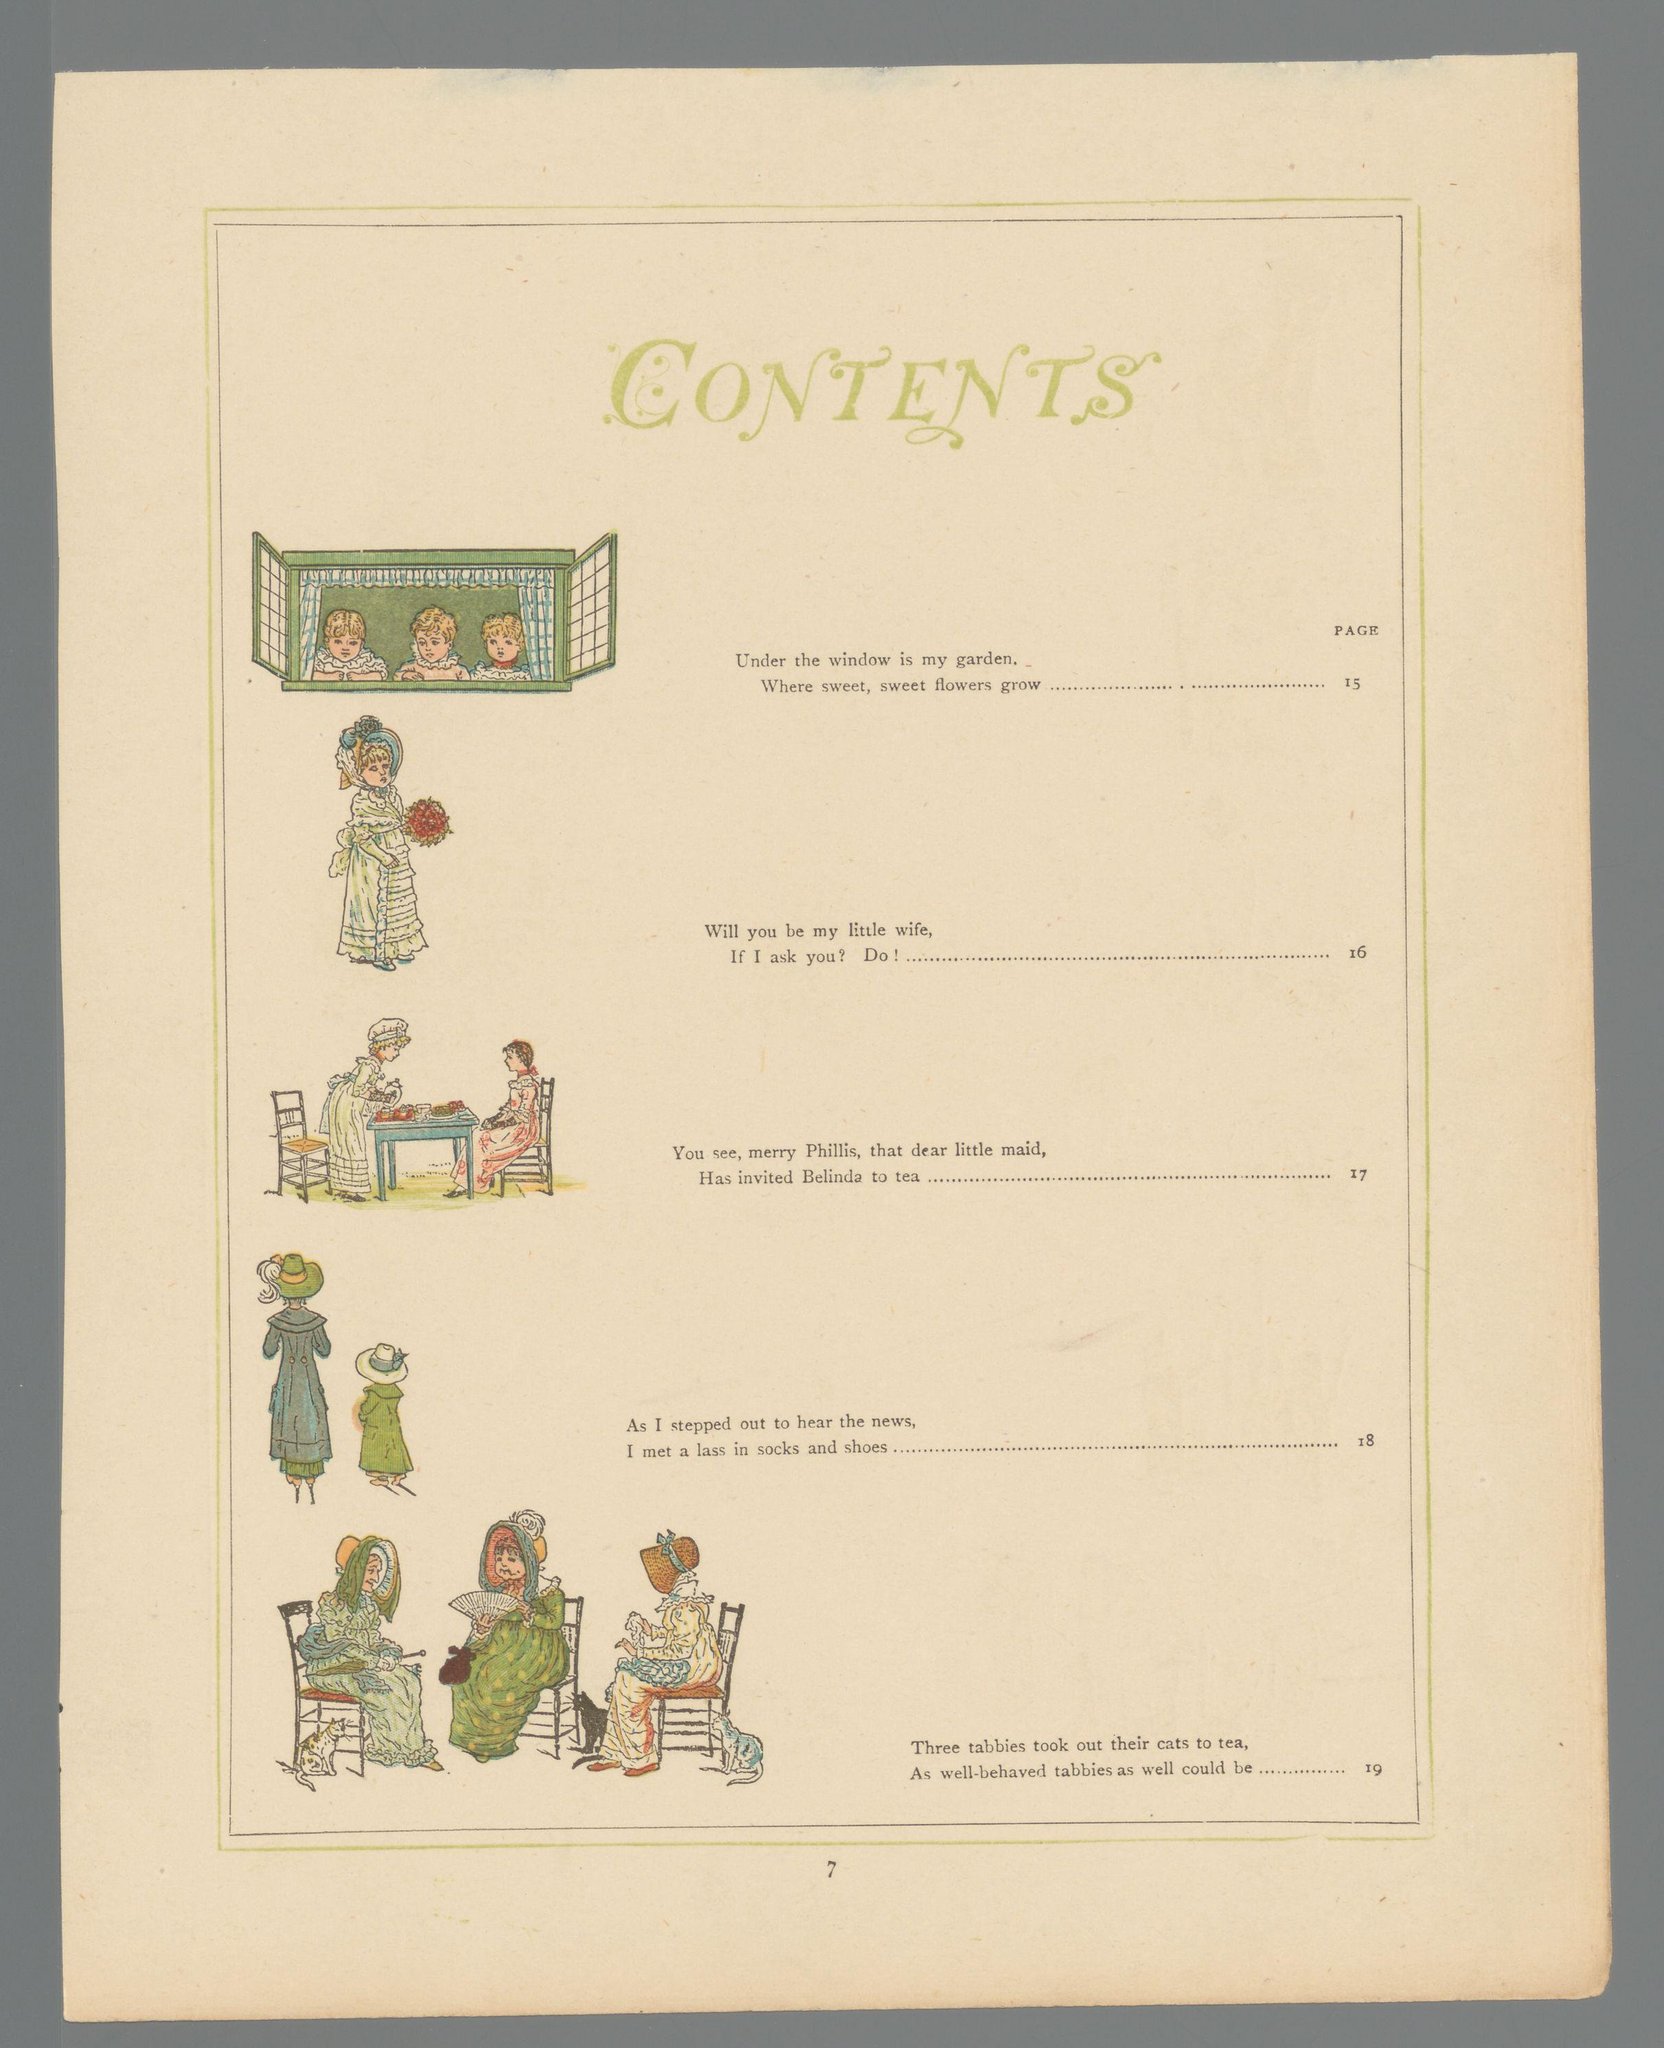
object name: print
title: Vijf genrevoorstellingen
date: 1878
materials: paper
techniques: wood engraving, letterpress printing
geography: london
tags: child, family life at home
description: Prent uit: Greenaway, Kate. Under the window, pictures & rhymes for children. Londen: George Routledge & Sons, 1878, p. 7.